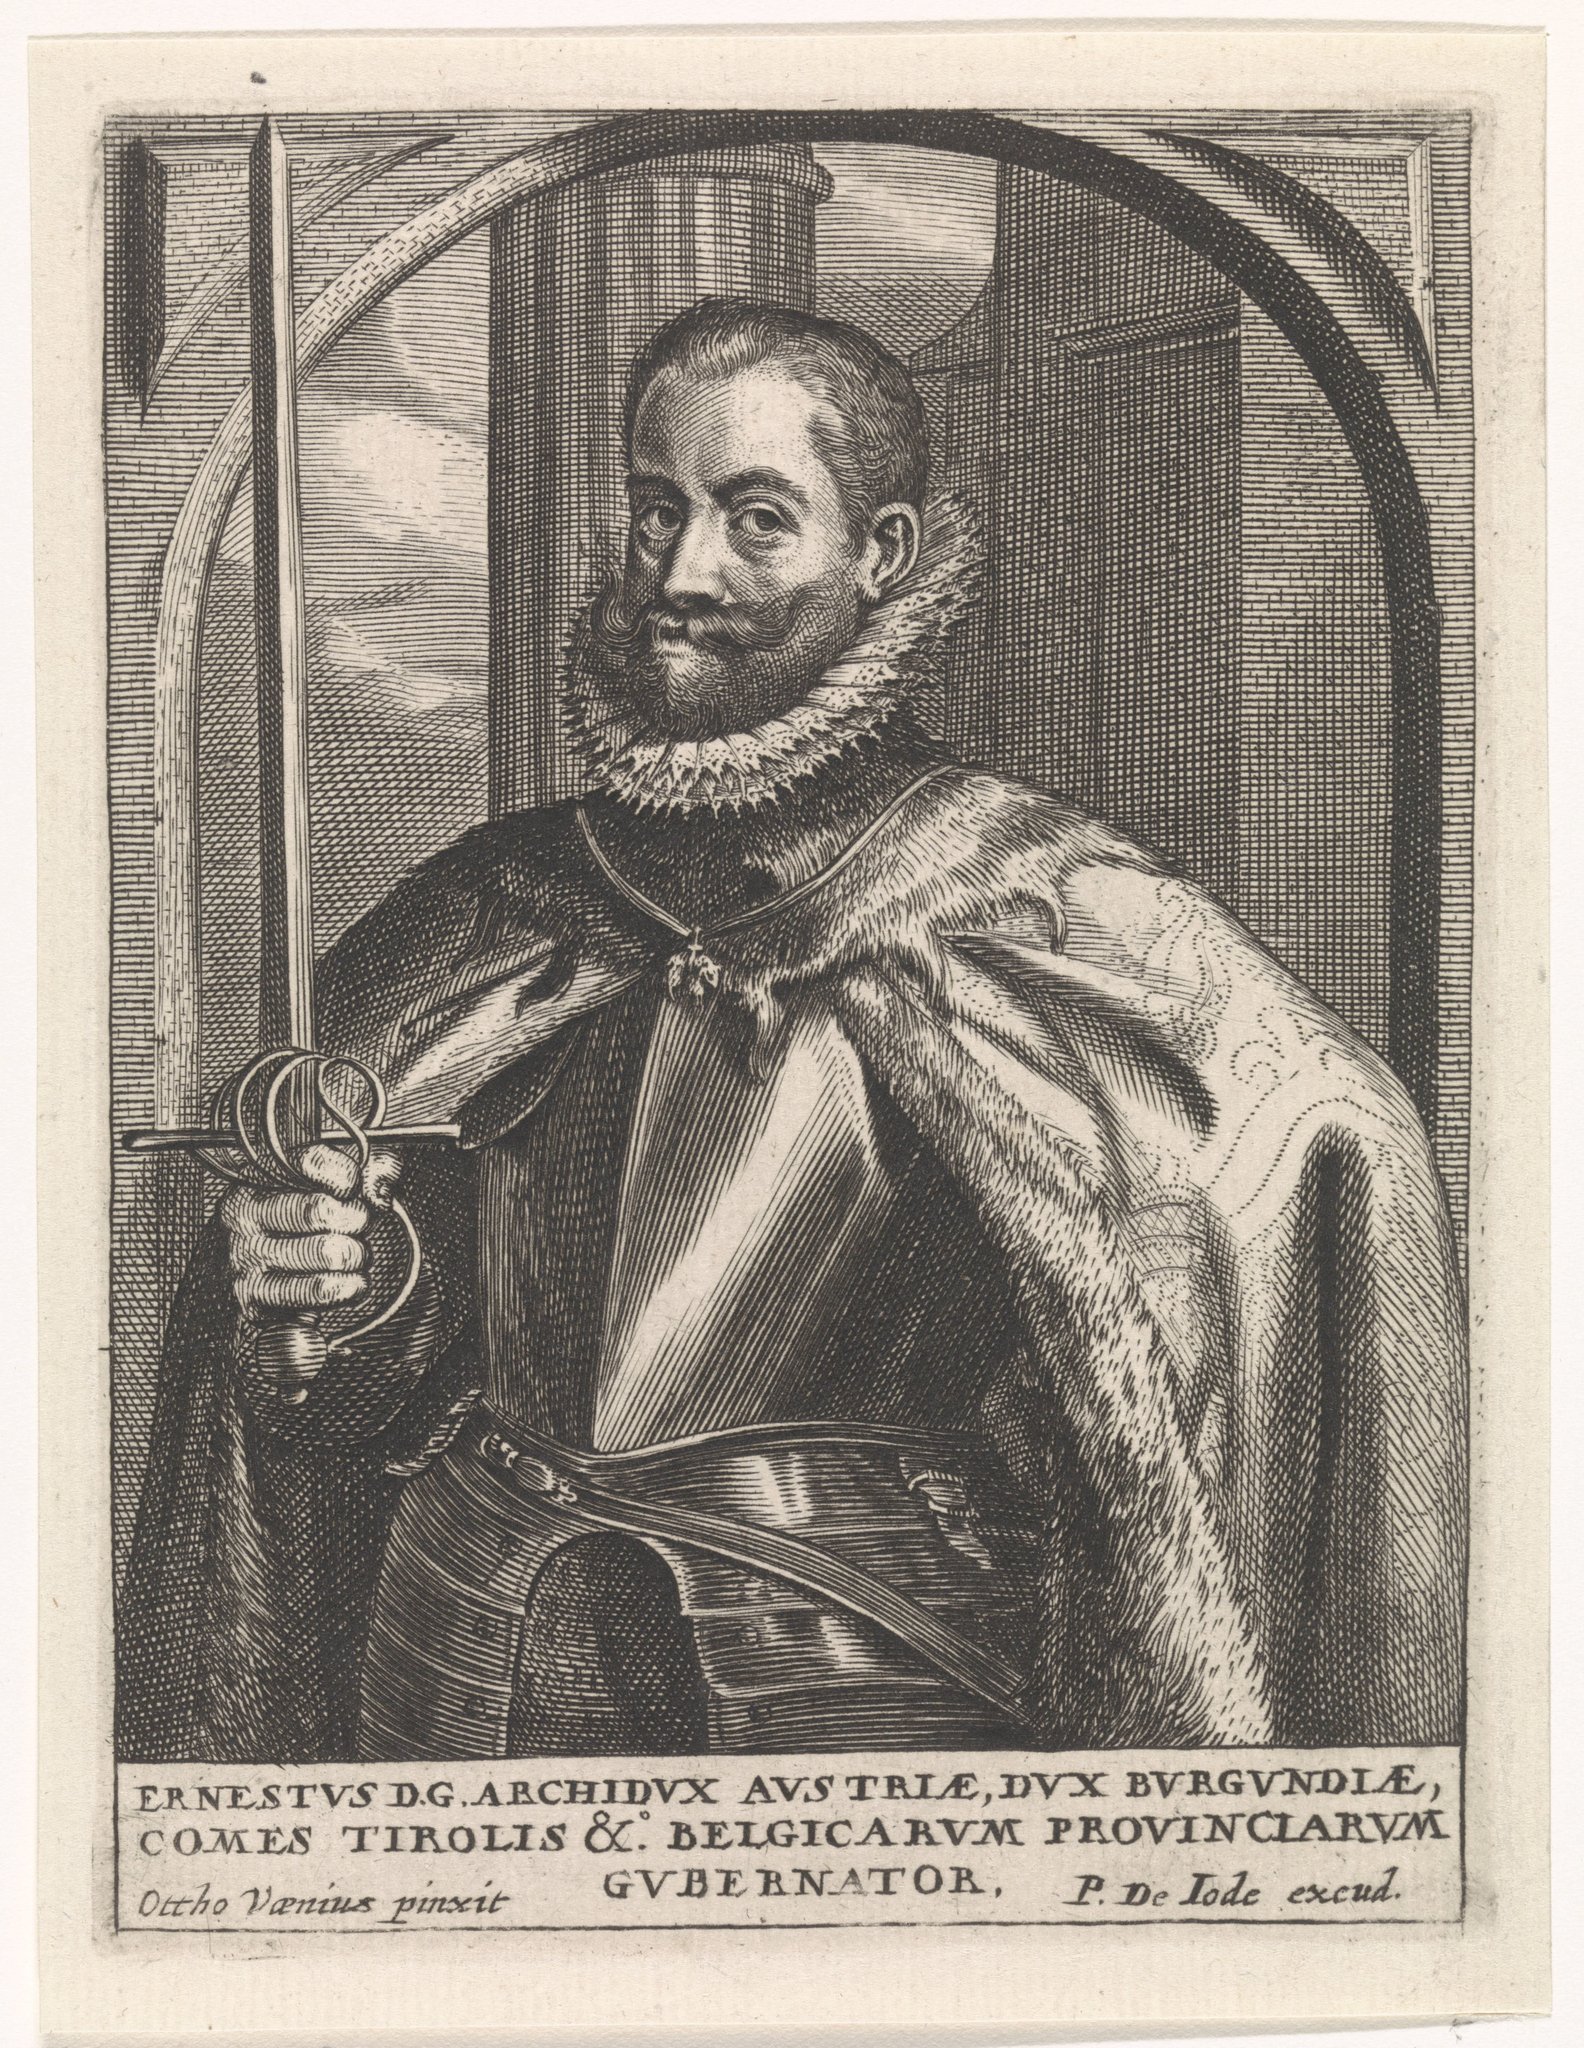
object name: print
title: Theatrum pontificum, imperatorum, regum, ducum, principum, etc.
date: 1628-1670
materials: paper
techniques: engraving, etching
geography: antwerp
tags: vienna, brussels, armour, historical persons, hacking and thrusting weapons: sword, emperor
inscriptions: collector's mark: Lugt 2228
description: Portret van Ernst van Oostenrijk, ten halven lijve. Hij draagt een harnas en een mantel. In zijn rechterhand houdt hij een zwaard. Het portret is gevat in een omlijsting. In de marge een drieregelig onderschrift in het Latijn.